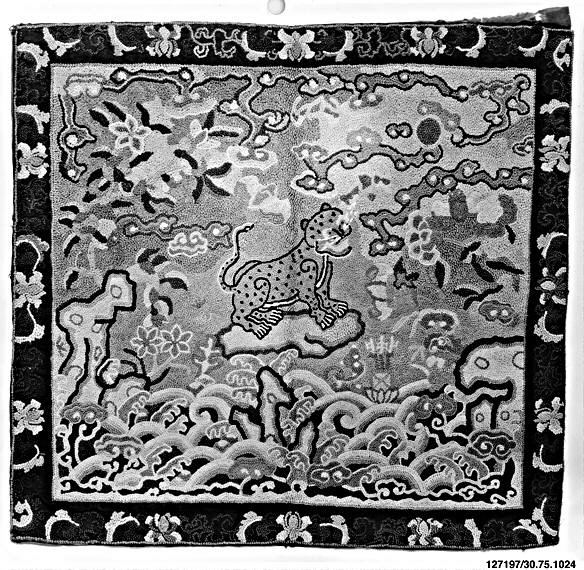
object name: rank badge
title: Rank Badge with Leopard on Rock with Waves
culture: chinese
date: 1767-1833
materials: silk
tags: leopards